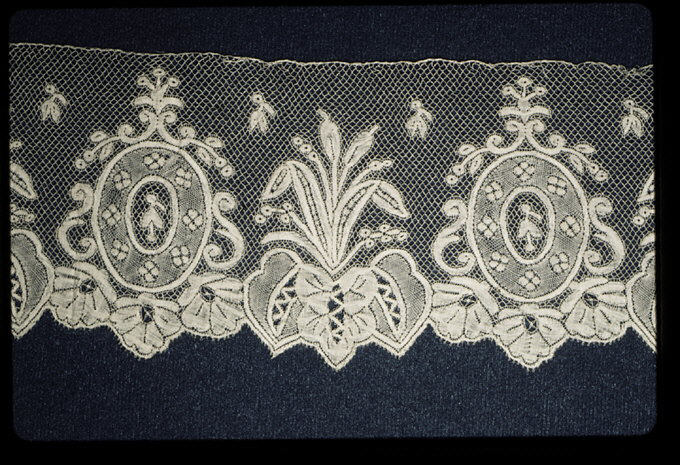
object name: border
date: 1801-1900